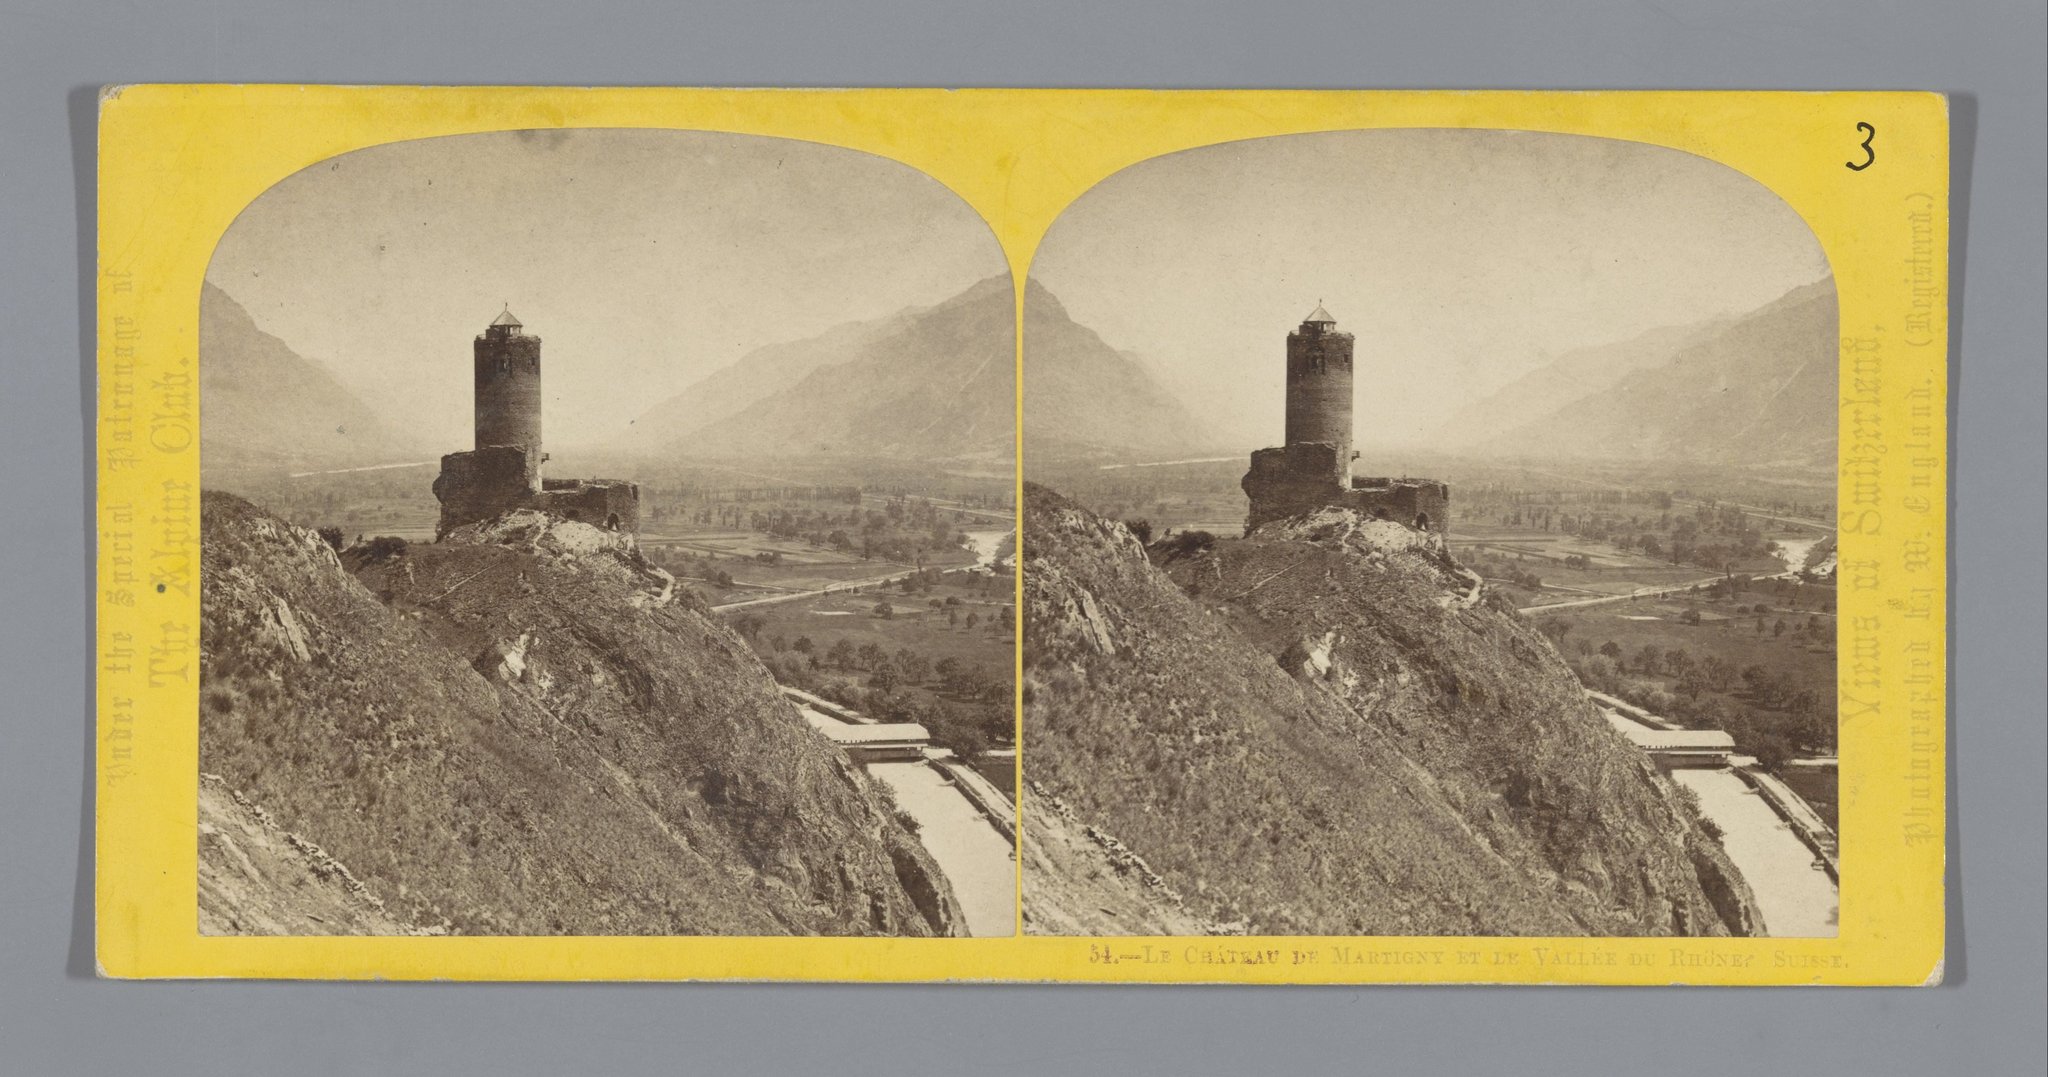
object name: stereograph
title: Le Château de Martigny et le Vallée du Rhone. Suisse.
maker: william england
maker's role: fotograaf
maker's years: 1816-1896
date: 1850-1880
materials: cardboard, photographic support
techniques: albumen print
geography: wallis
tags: dale, valley, castle, façade (of house or building)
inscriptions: inscription: ‘Views of Switzerland, photographed by W. England. (Registered) Under the Special Patronage of the Alpine Club.’, number: ‘54.’